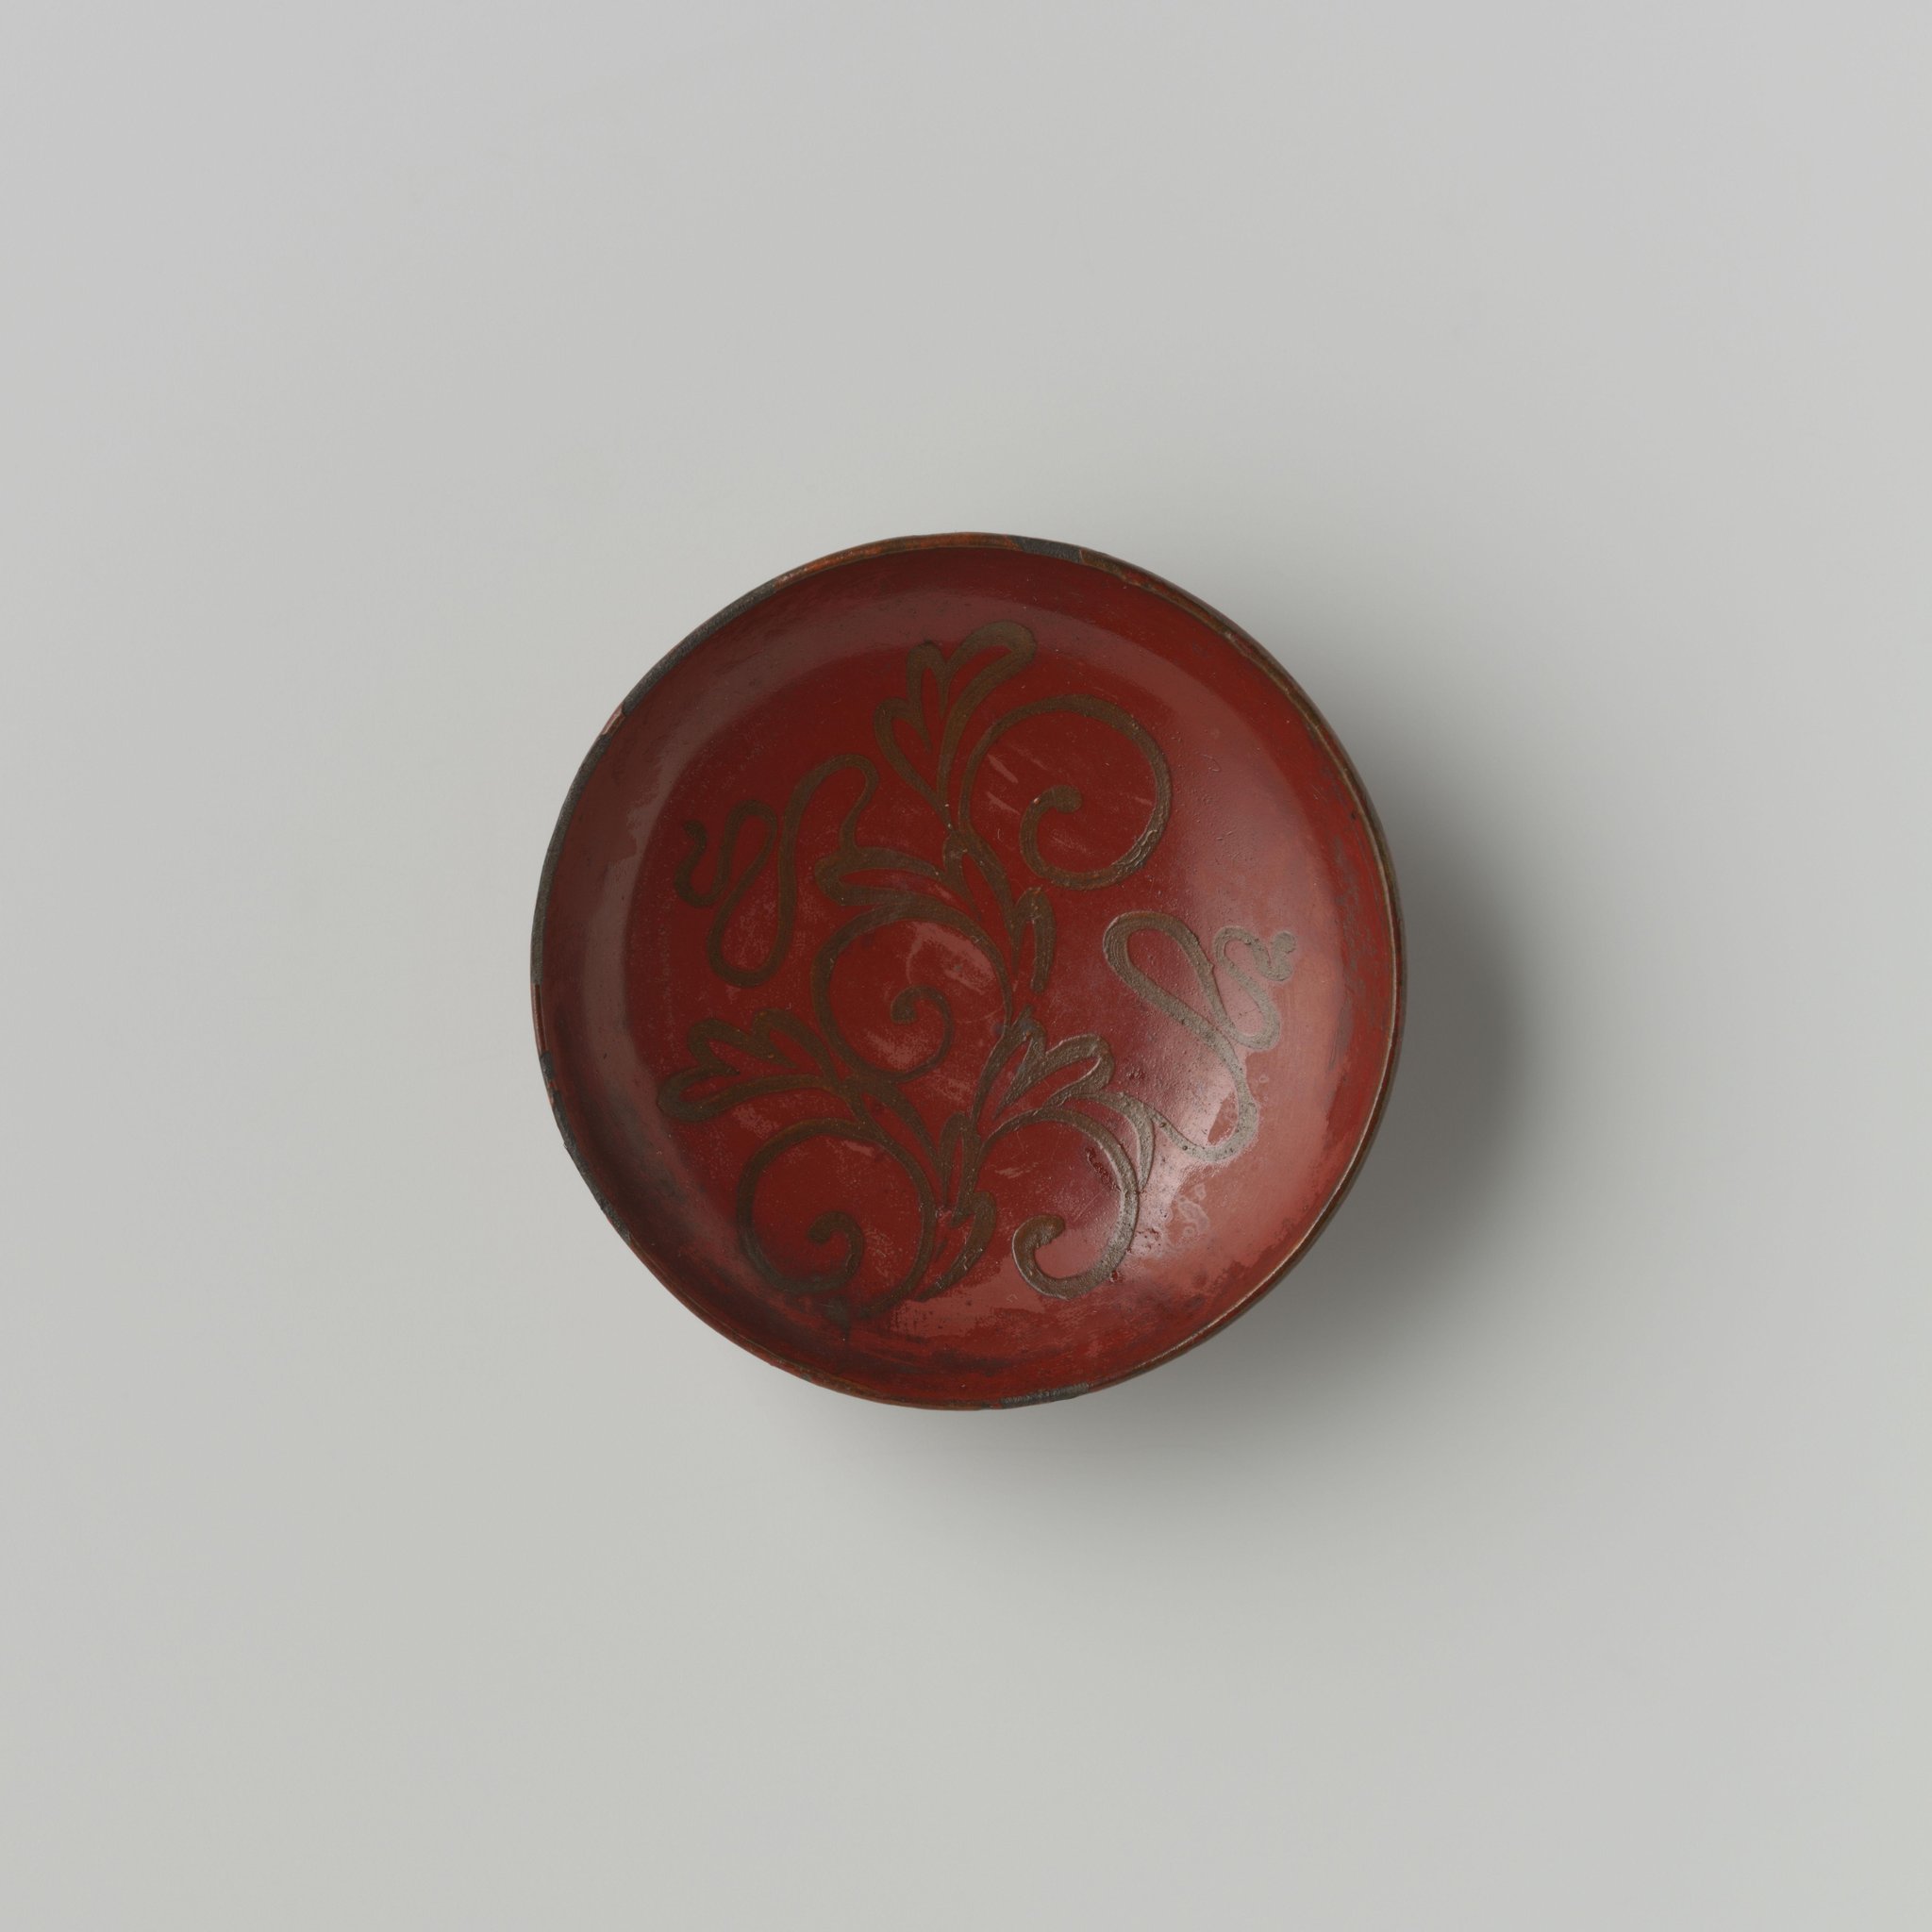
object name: miniature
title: Ronde schotel, gedraaid van hout en geheel bedekt met een rode laklaag; decoratie van bloemrank in goudverf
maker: Anonymous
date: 1690-1710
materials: wood, paint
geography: amsterdam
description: Eén van twee ronde schotels, gedraaid van hout en geheel bedekt met een rode laklaag; in de schotel decoratie van bloemrank (BK-NM-1010-279-B en oosterse boom), in goudverf (imitatie oosters lakwerk). De glanzende rode lak vertoont deels matte plekken en er schemert een zwarte onderlaag doorheen. De standring aan de onderzijde is doorboord en bevat een ophangoogje van koperdraad.